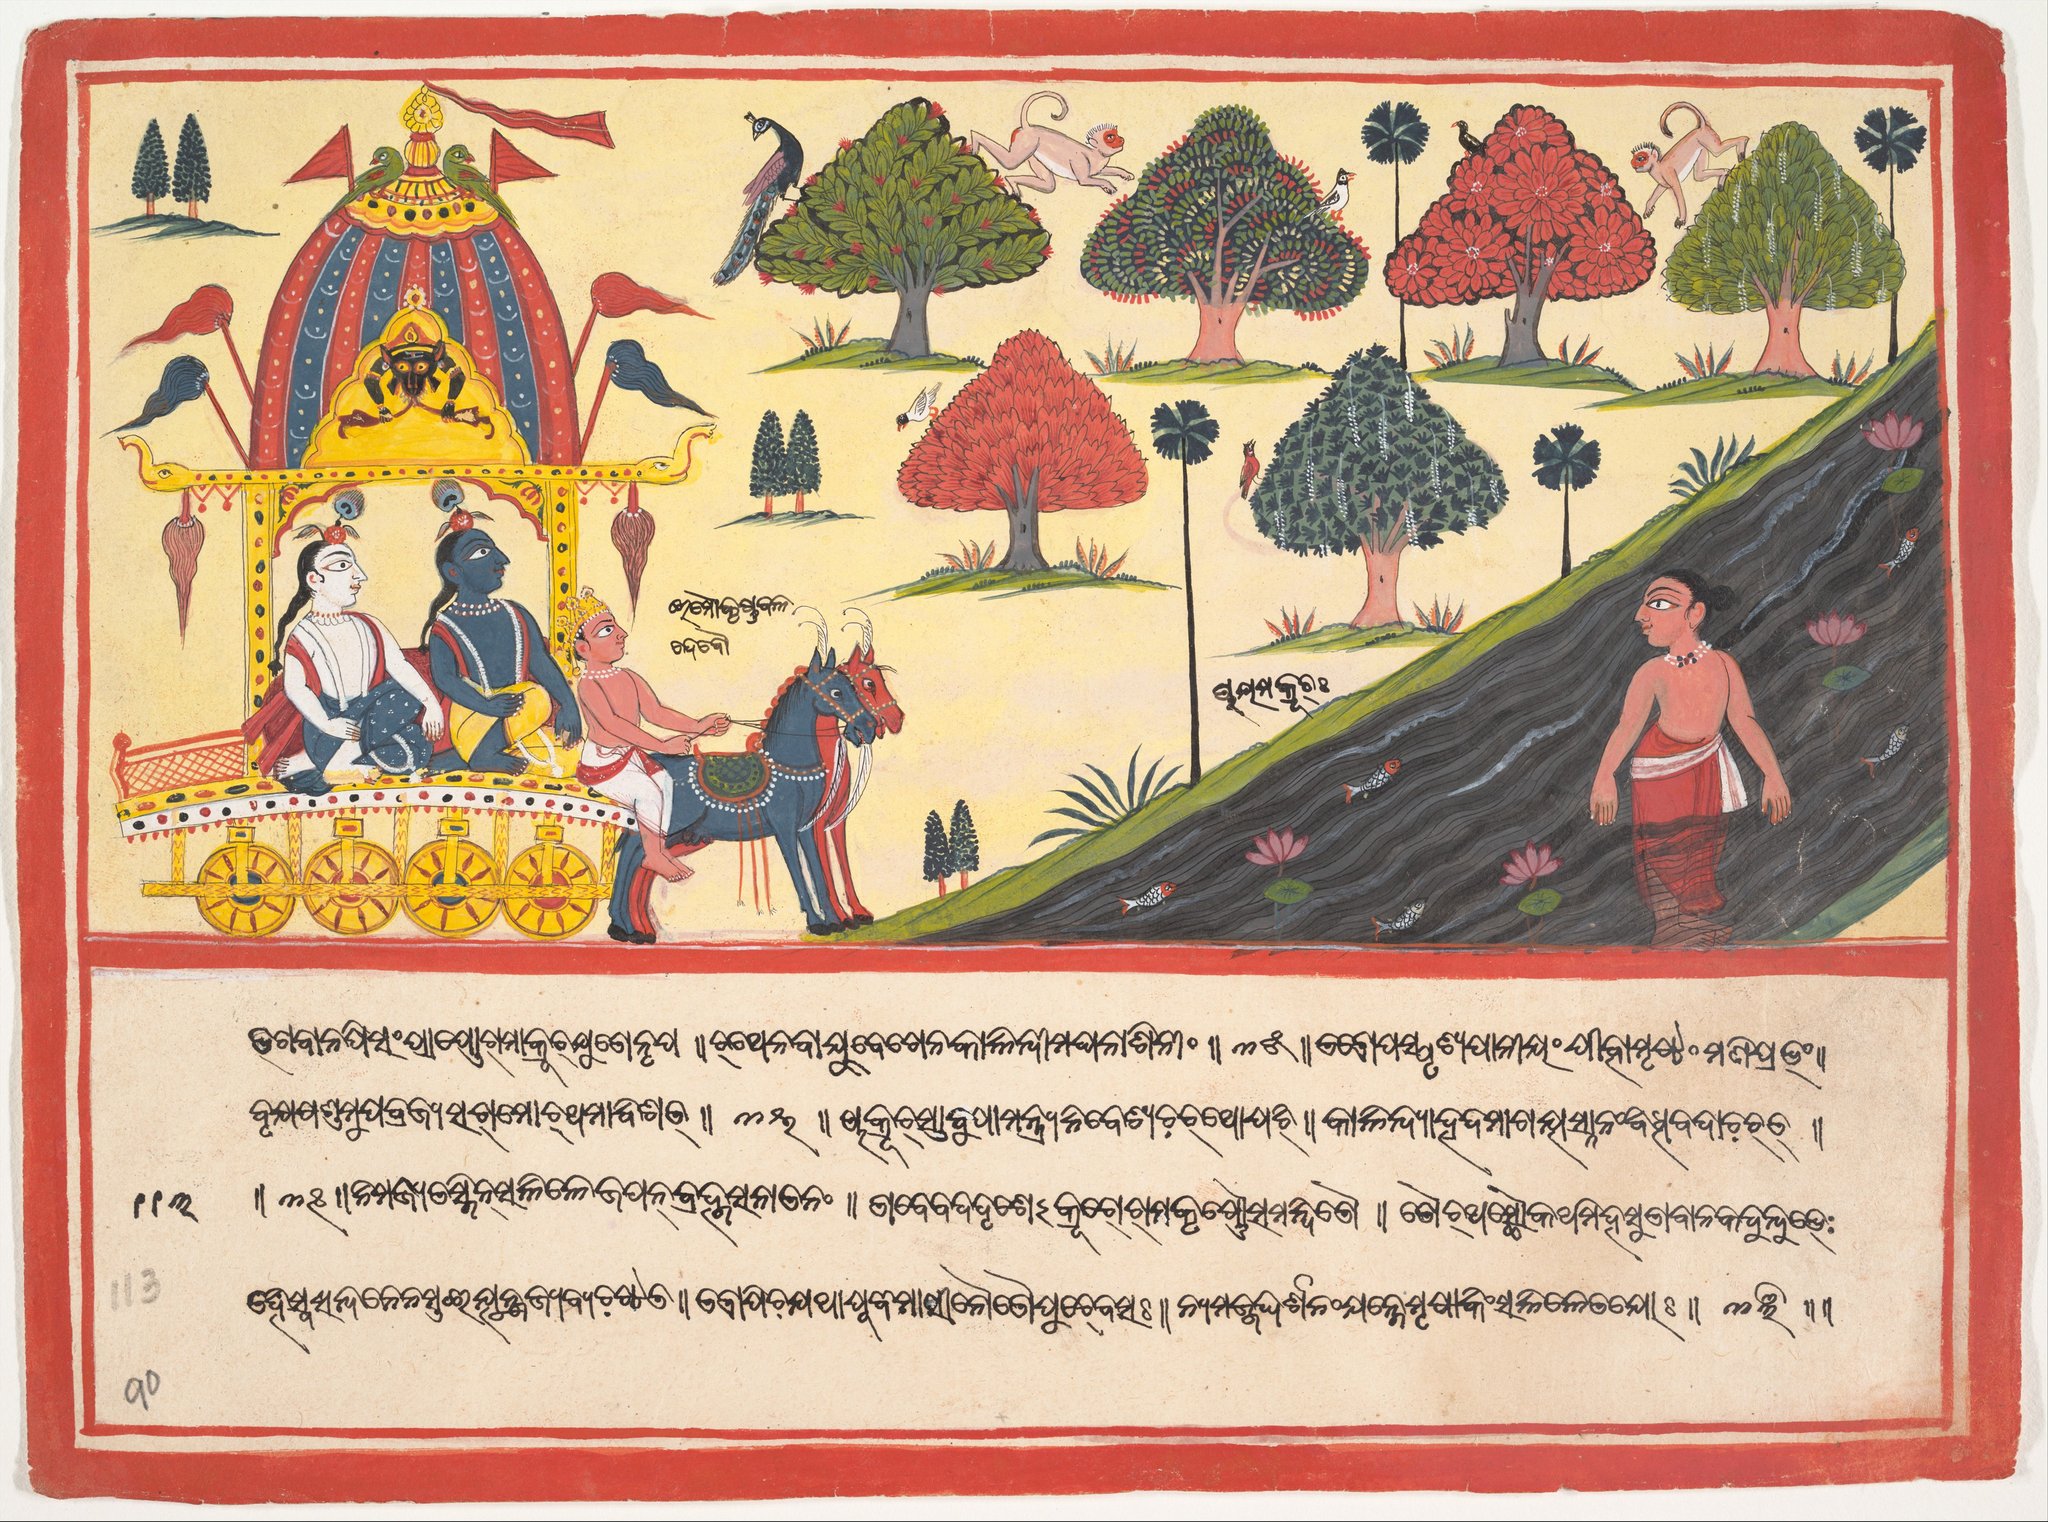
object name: folio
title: Krishna and Balarama by a River: Page from a Dispersed Bhagavata Purana (Ancient Stories of Lord Vishnu)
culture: indian, orissan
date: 1840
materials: ink, paper, watercolor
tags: horses,monkeys,krishna,chariots